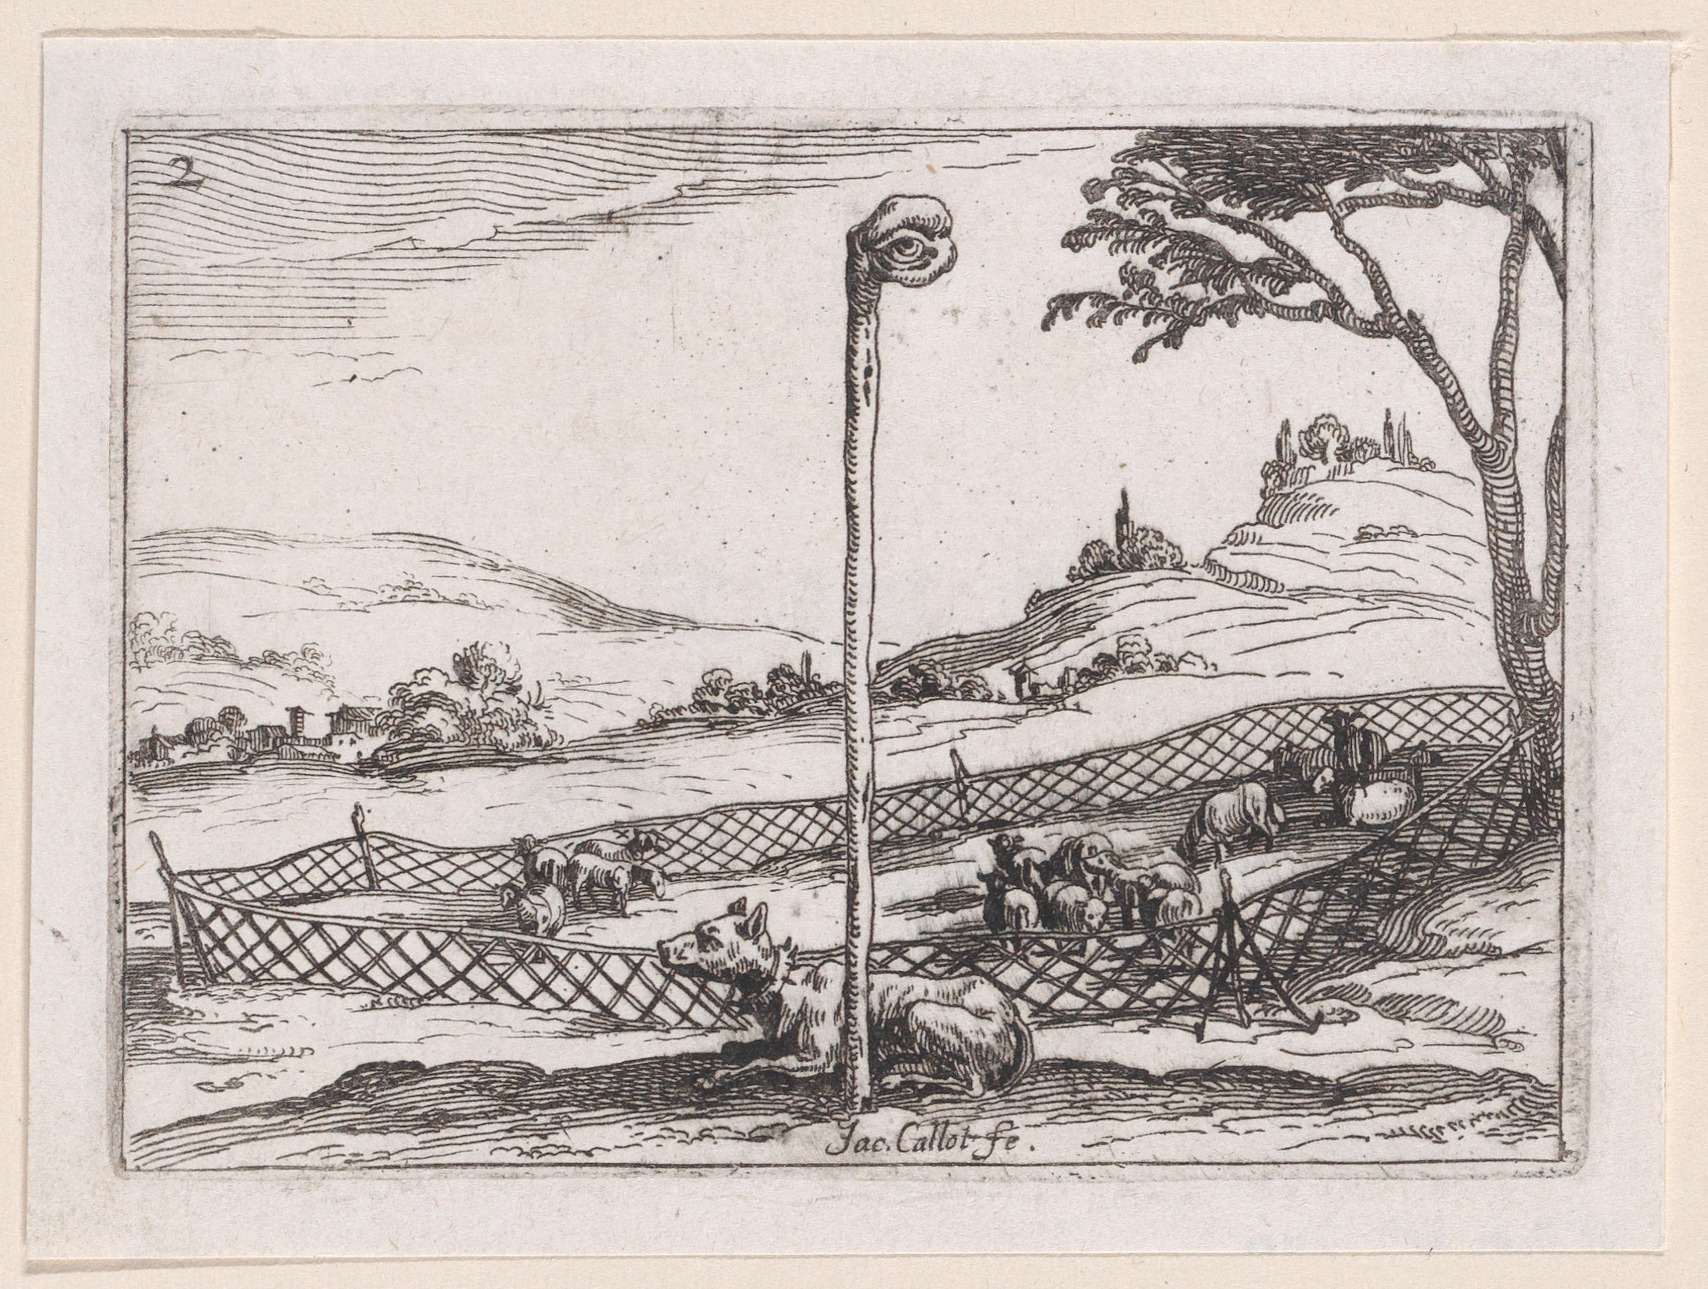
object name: print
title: L'Oeil Vigilant (The Watchful Eye), plate 2 from "Lux Claustri ou La Lumière du Cloitre" (The Light of the Cloisters)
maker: jacques callot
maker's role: artist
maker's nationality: french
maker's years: 1592-1635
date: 1621-1635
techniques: etching